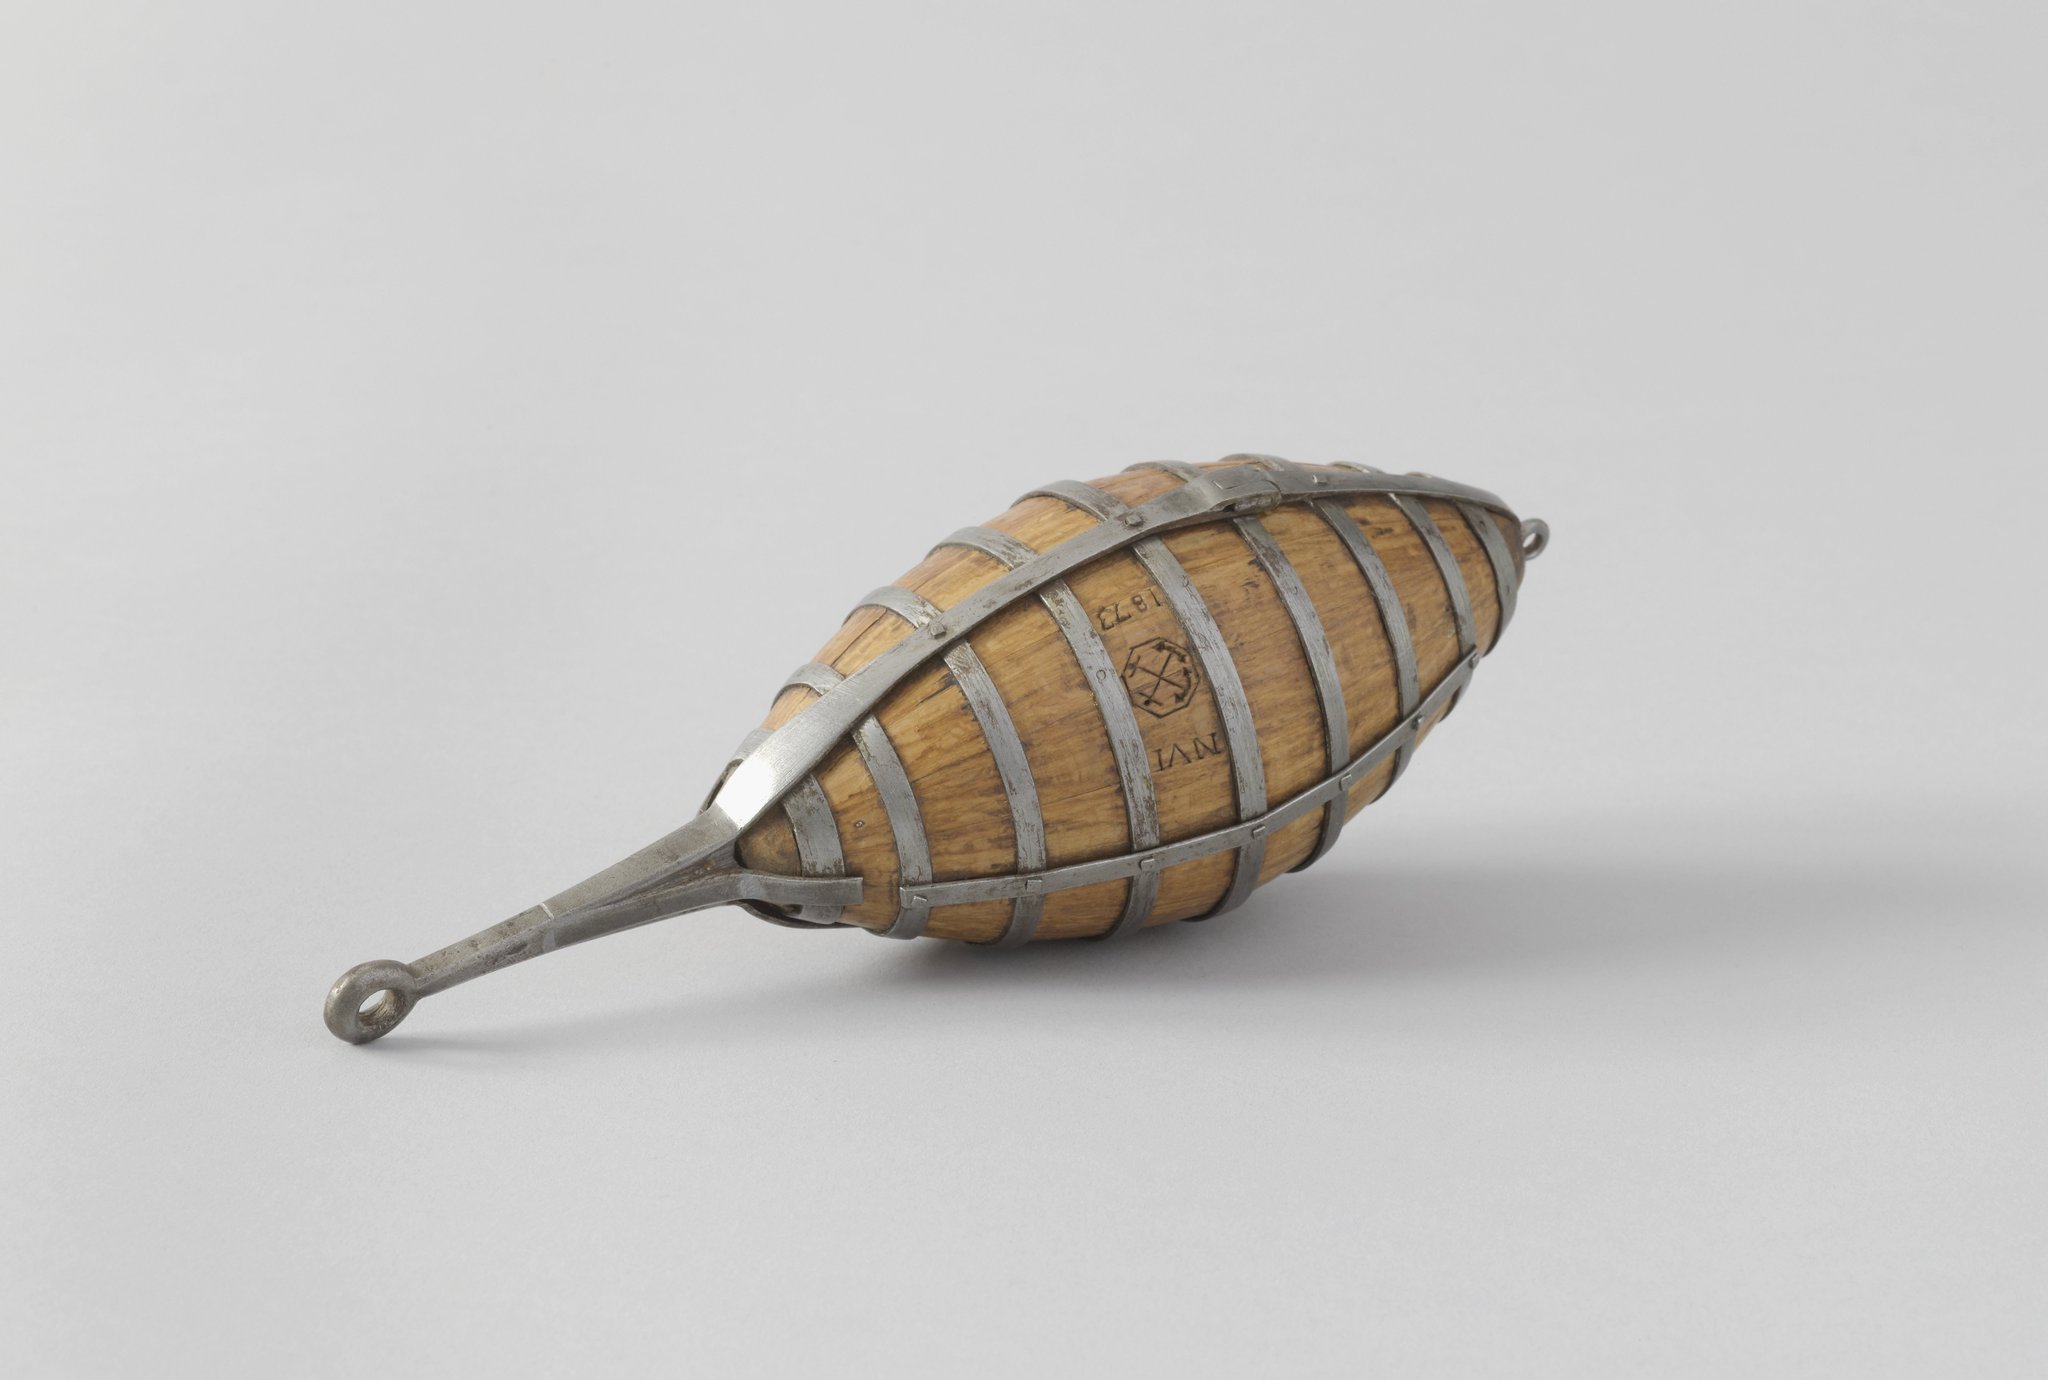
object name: demonstration model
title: Model of a Buoy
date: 1873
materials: iron, wood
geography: enkhuizen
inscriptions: inscription: ‘NVI / 1873’, monogram: crossed anchors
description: Model van een boei met een conisch lichaam met scherpe uiteinden en rond van doorsnee. Zoals een vat is zij samengesteld uit duigen en hoepels. Bovenop zit een oog, evenals onderaan aan een lange punt voor de ankerketting. Gemerkt met gekruiste ankers. Model behoort bij serie van zes boeien van verschillende formaten. Schaal 1:10 (archief).